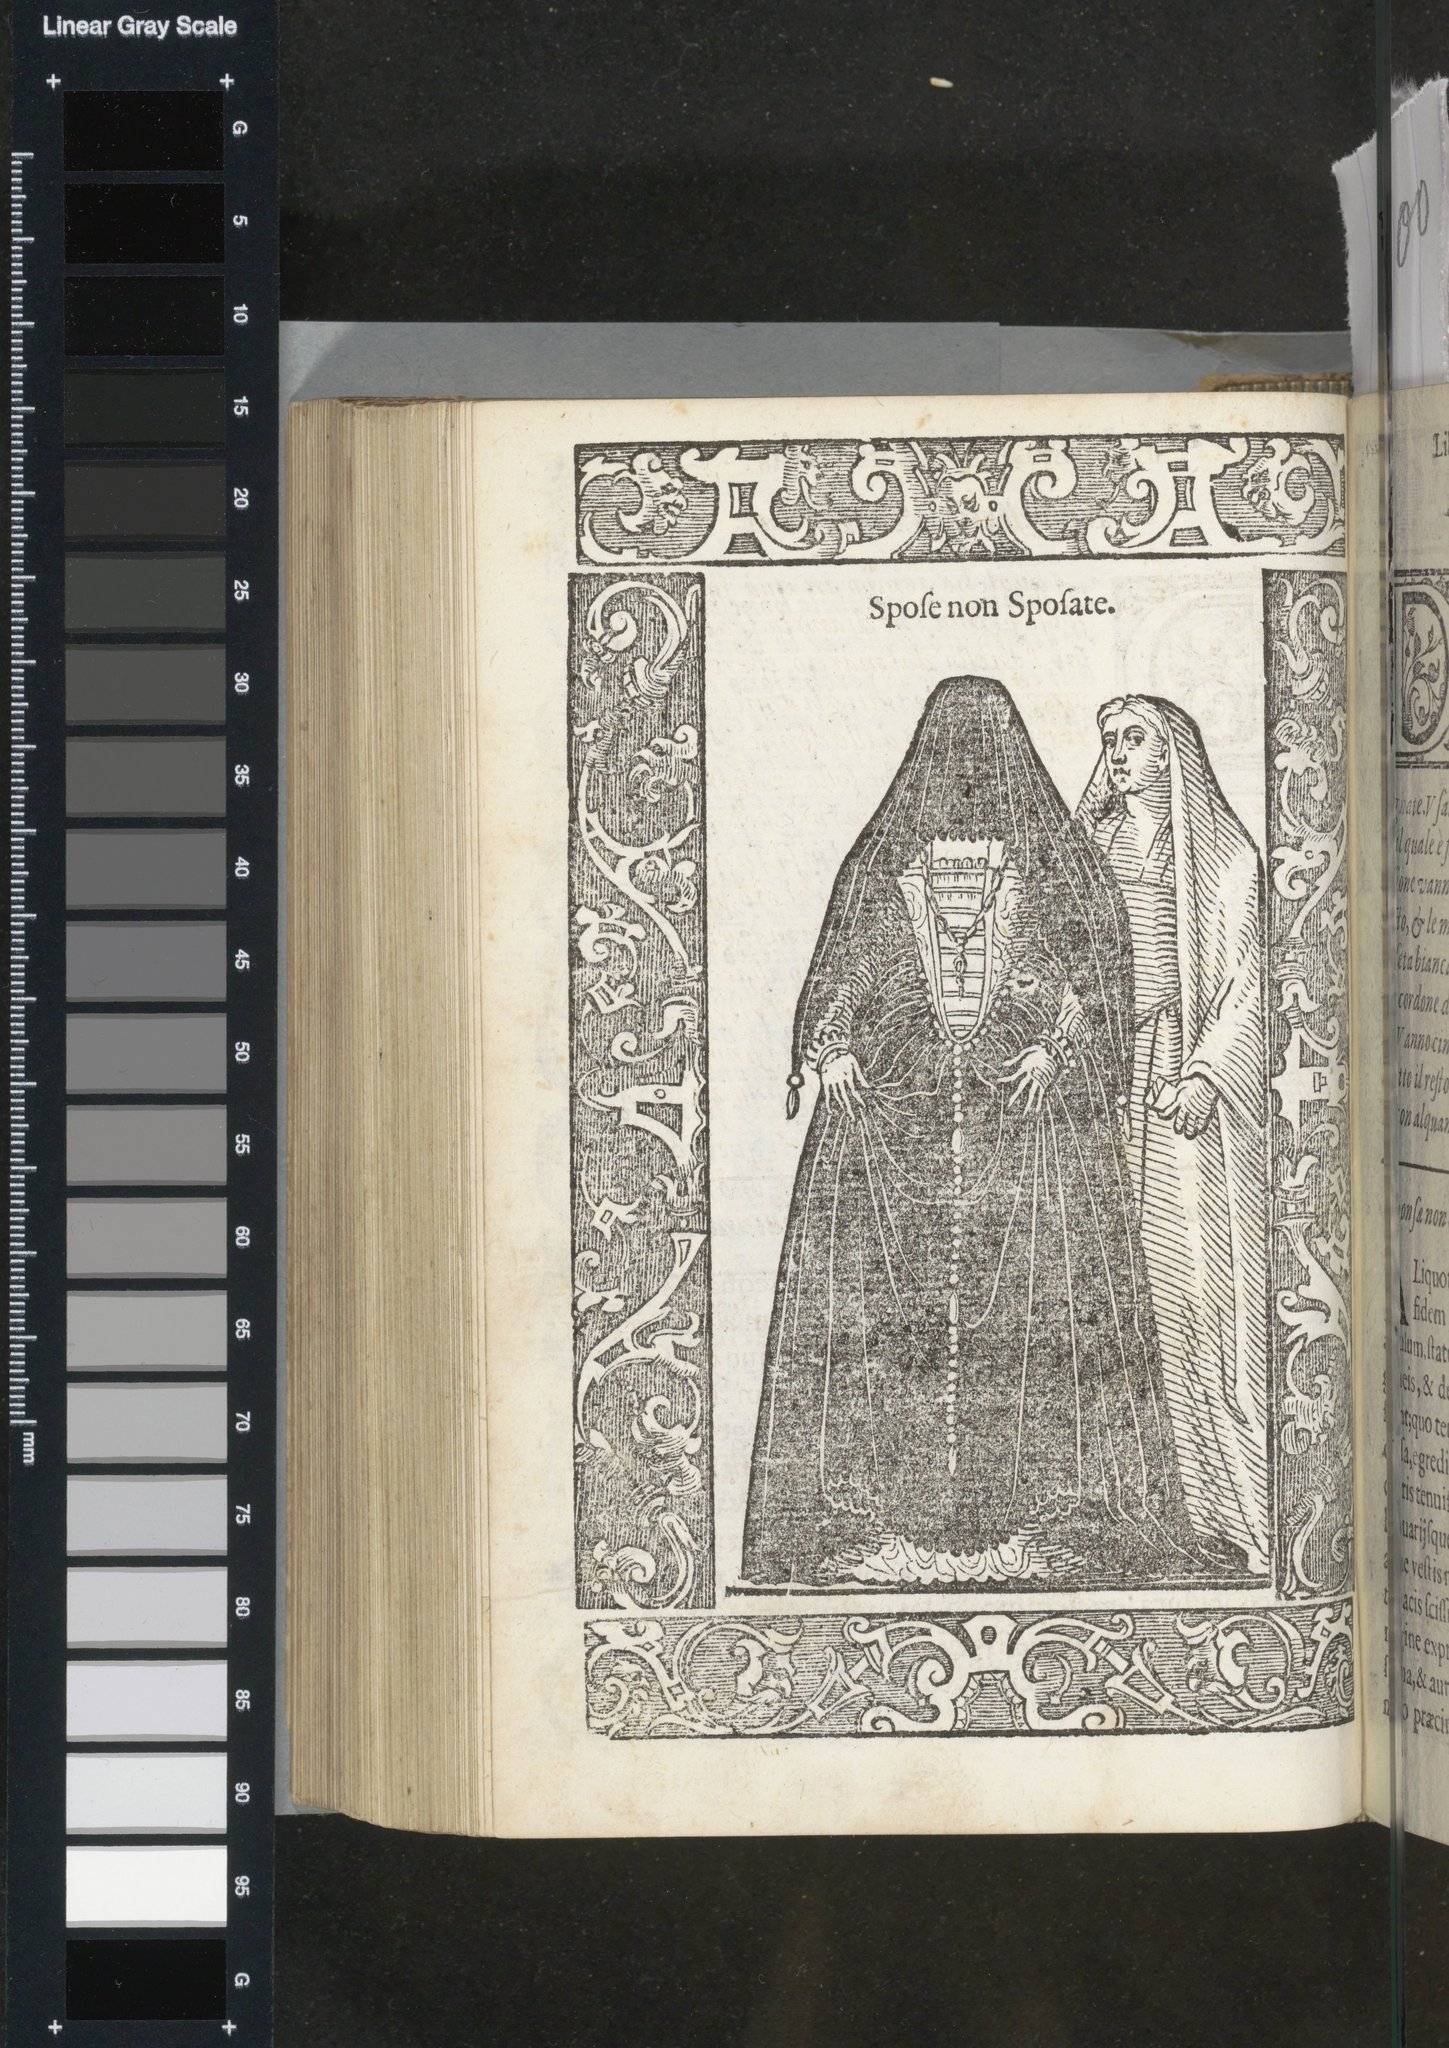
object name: costume print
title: Ongetrouwde adellijke jonge vrouw uit Venetië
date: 1598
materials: paper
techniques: woodcut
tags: veil (+ women's clothes), fashion plates, dress, gown (+ women's clothes), maid ~ house personnel, necklace (+ women's clothes), belt, girdle, waistband (+ women's clothes)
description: Ongetrouwde adellijke Venetiaanse jonge vrouw in een zwart overkleed en een zwarte 'fazzuolo' of sluier over het hoofd die het gezicht bedekt. Een gouden keten om de hals en een gouden ceintuur om het middel. Zij wordt begeleid door haar chaperone.